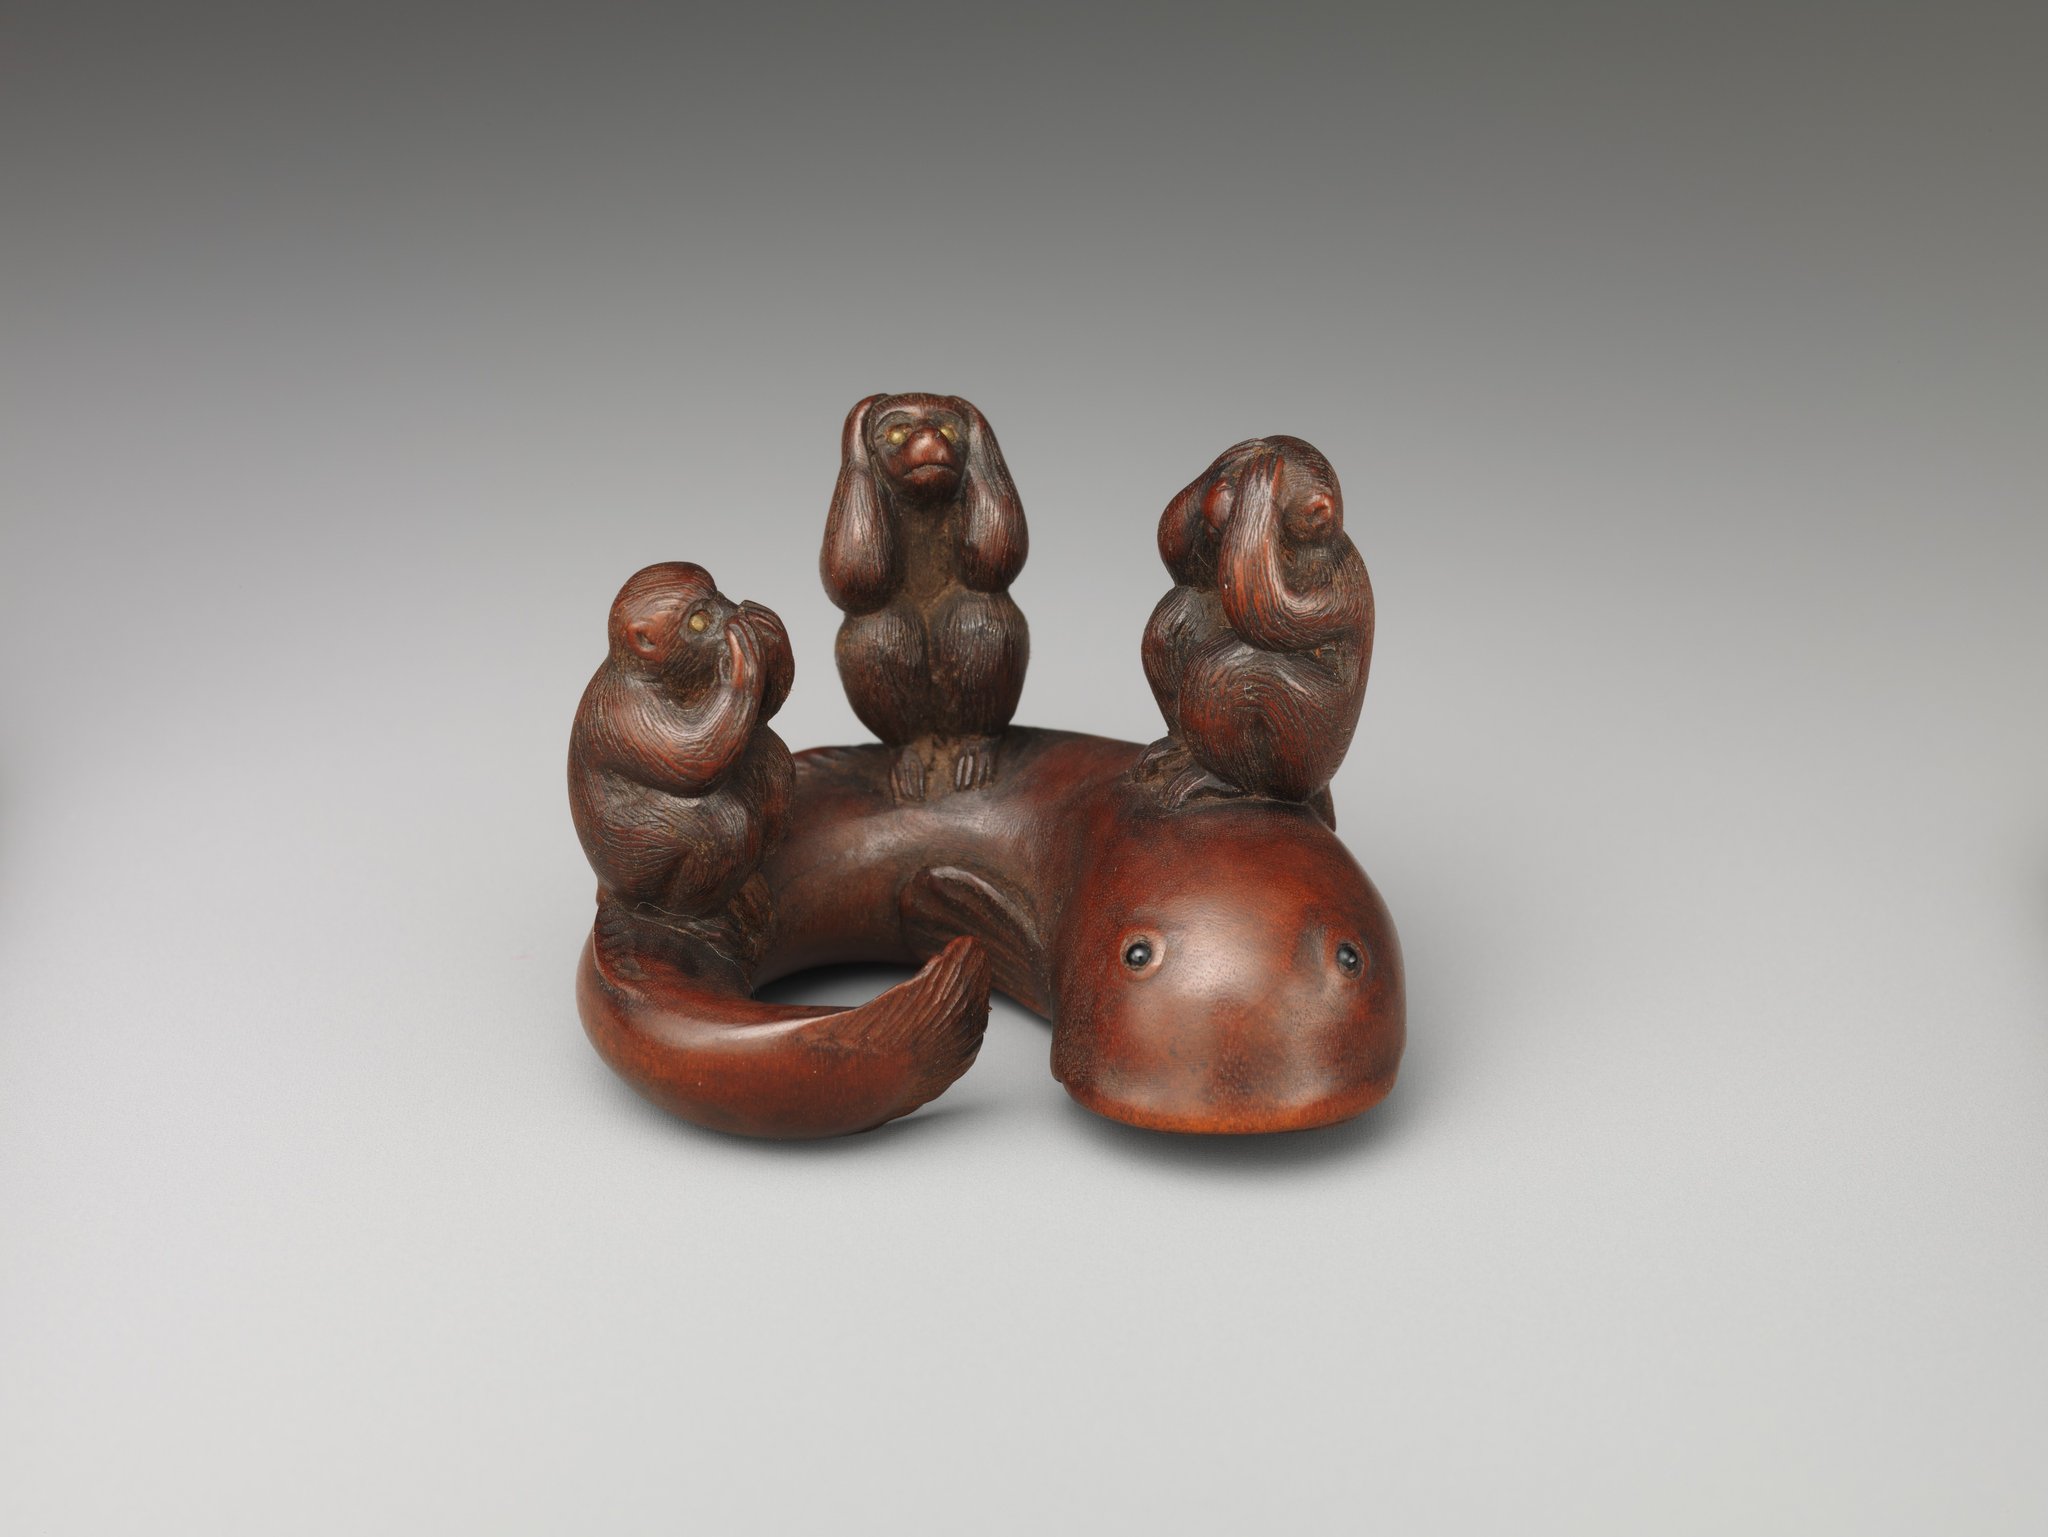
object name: netsuke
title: Netsuke of Three Monkeys on the Back of a Fish (Sanbiki Saru)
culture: japanese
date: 1801-1900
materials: wood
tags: fish,monkeys